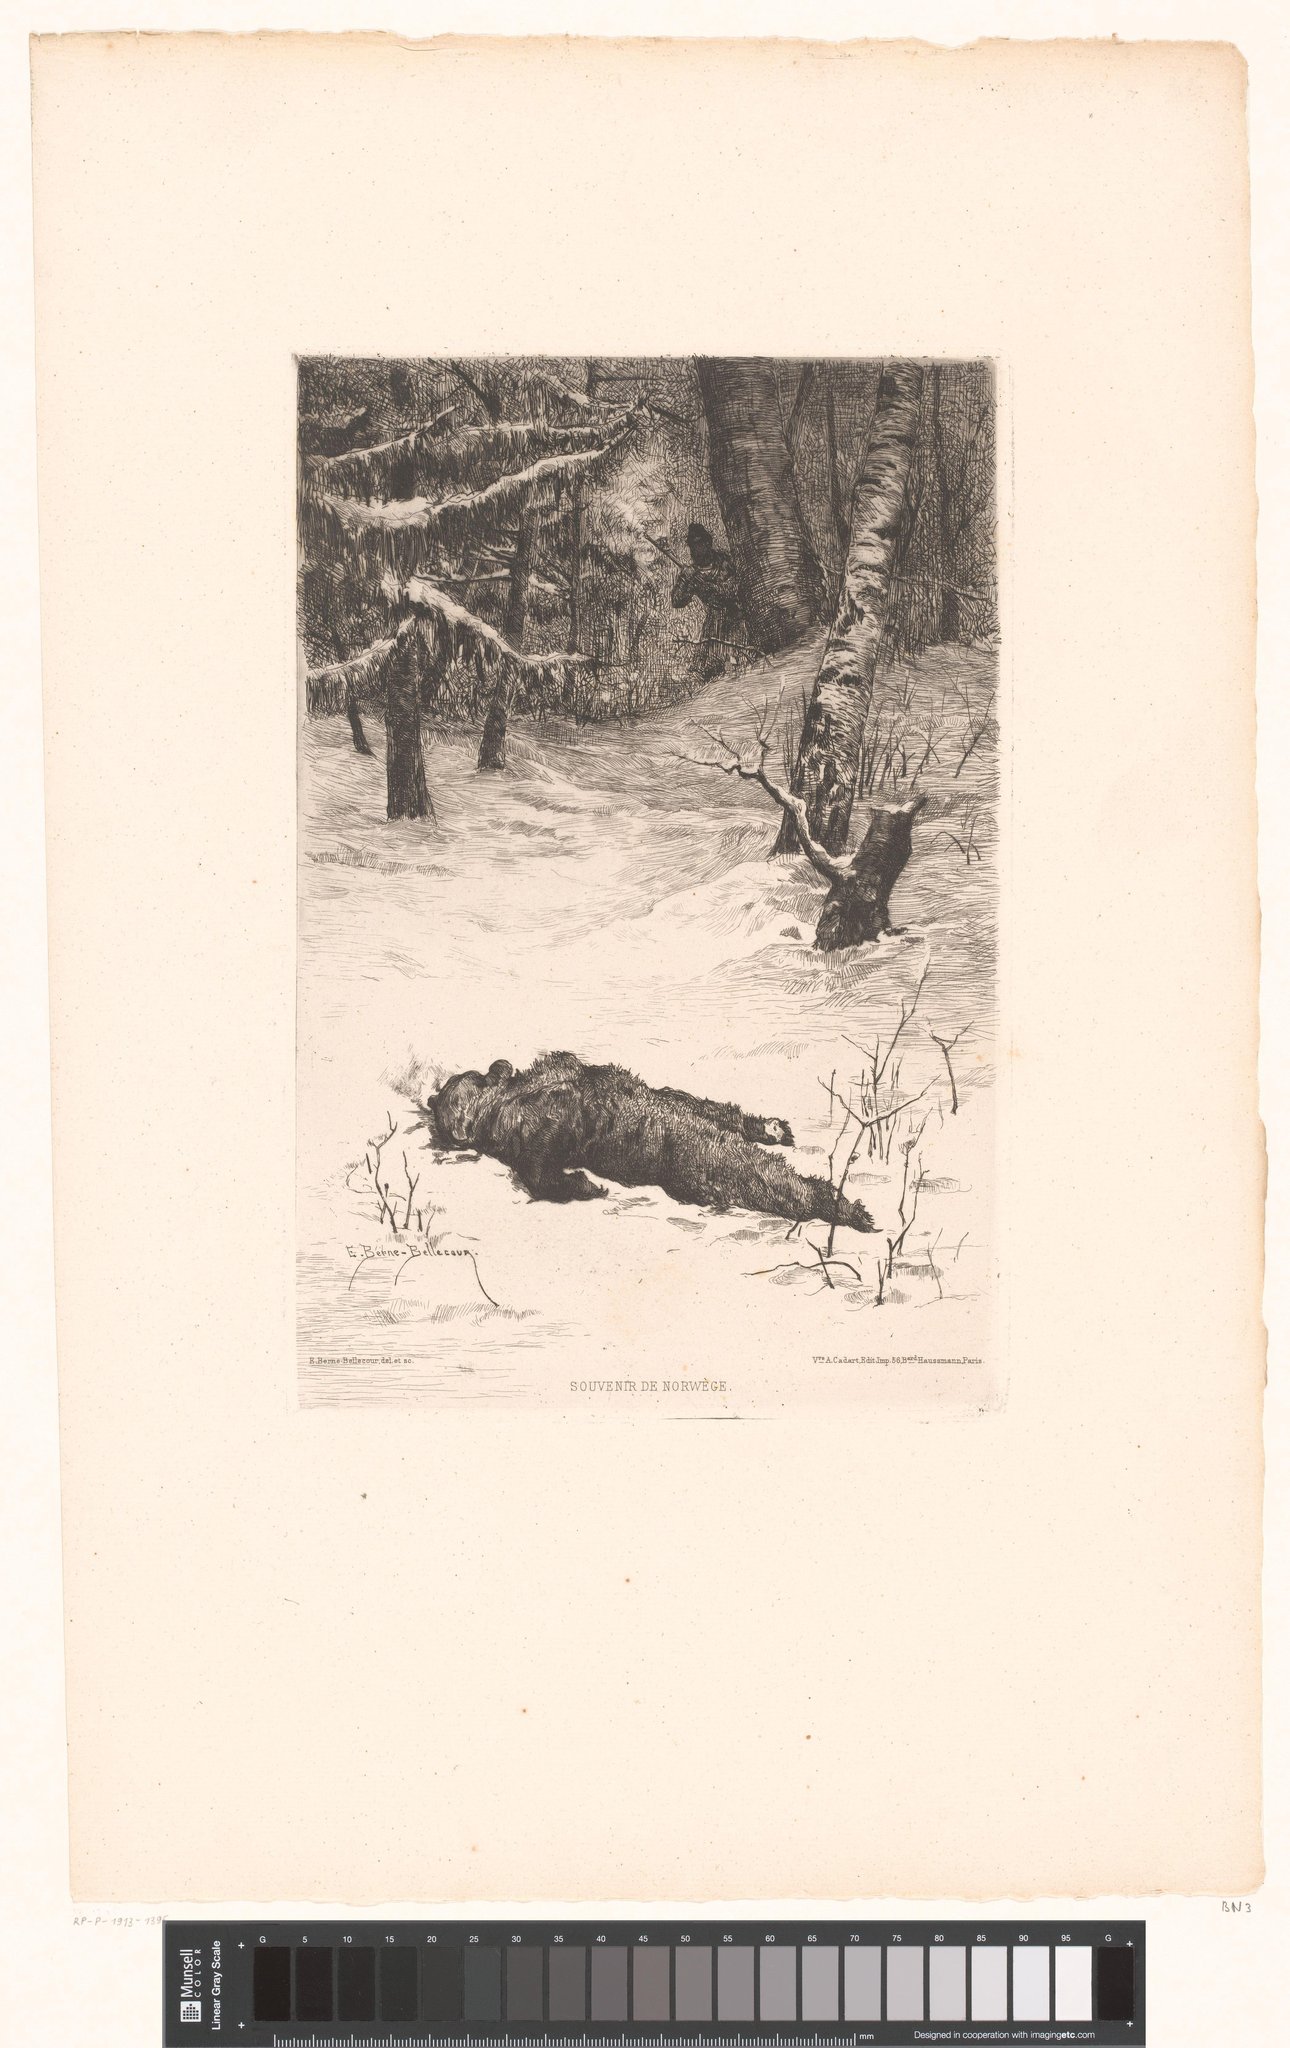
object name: print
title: Jager in de sneeuw met neergeschoten beer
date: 1845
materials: paper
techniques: drypoint, etching, intaglio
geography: france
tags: beasts of prey, predatory animals: bear, forest, wood, snow, hunt ~ mammals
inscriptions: collector's mark: Lugt 2233